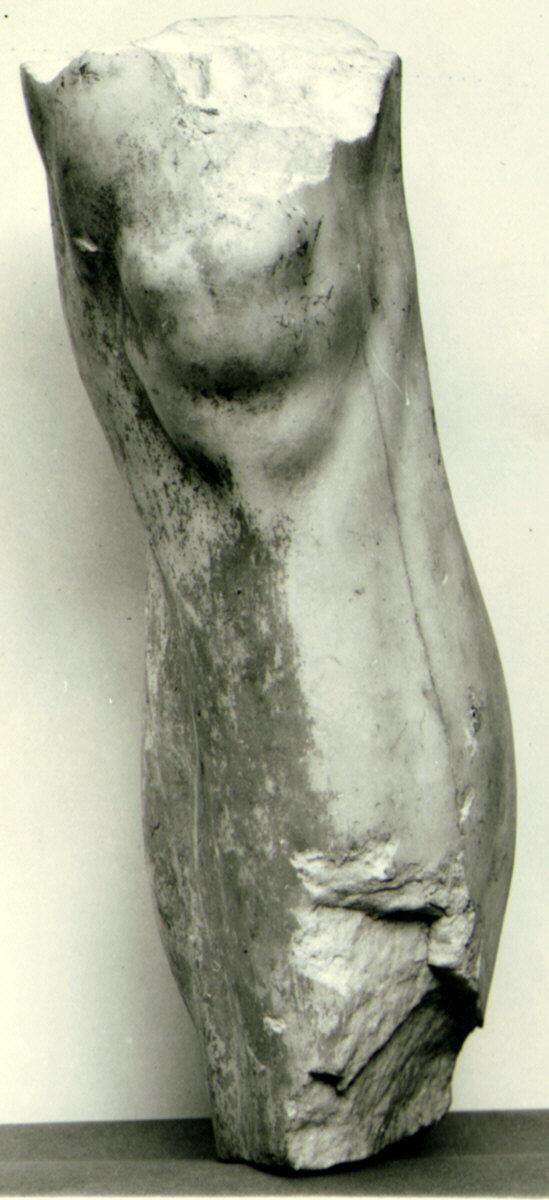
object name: statue of caracalla, fragment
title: Marble fragments of a statue of the emperor Caracalla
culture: roman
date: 217-230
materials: marble